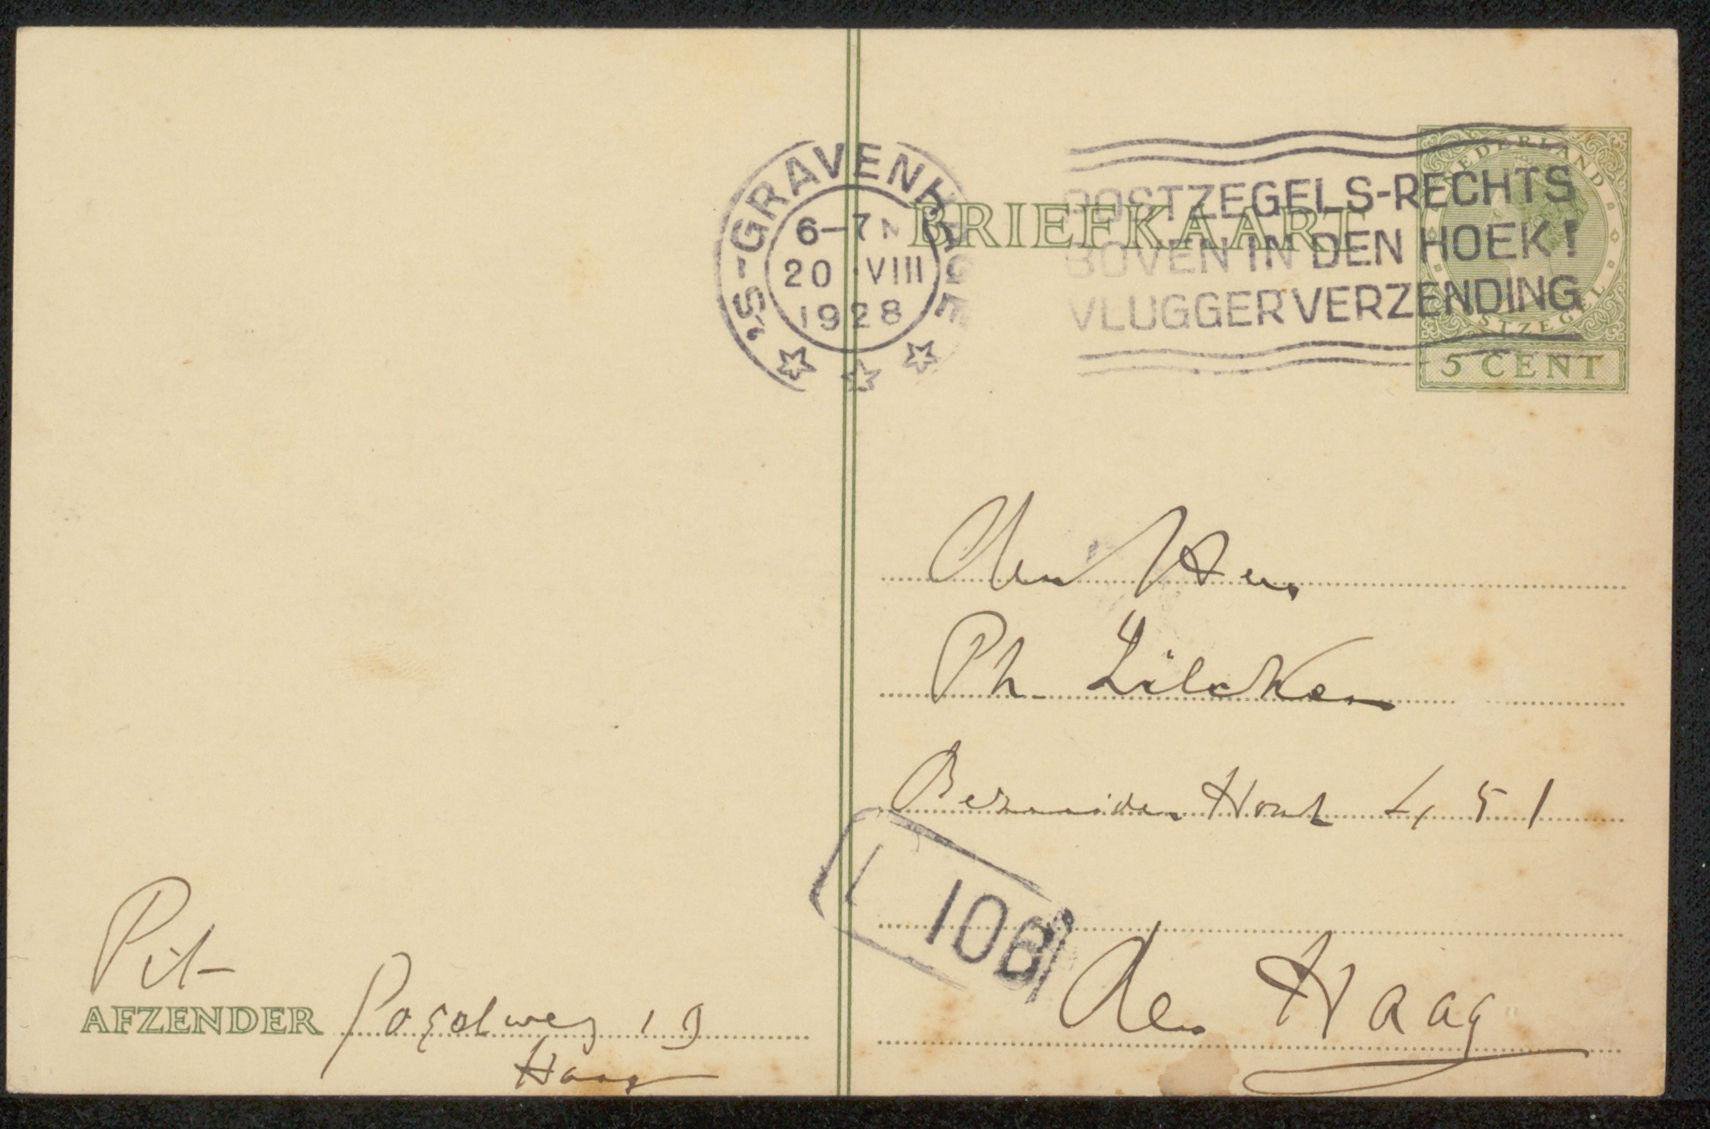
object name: postcard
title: Briefkaart aan Philip Zilcken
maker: adriaan pit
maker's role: print maker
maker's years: 1860-1944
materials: cardboard, ink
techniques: pen, writing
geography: the hague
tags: painter, philip zilcken, diseases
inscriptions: collector's mark: ‘RPK’